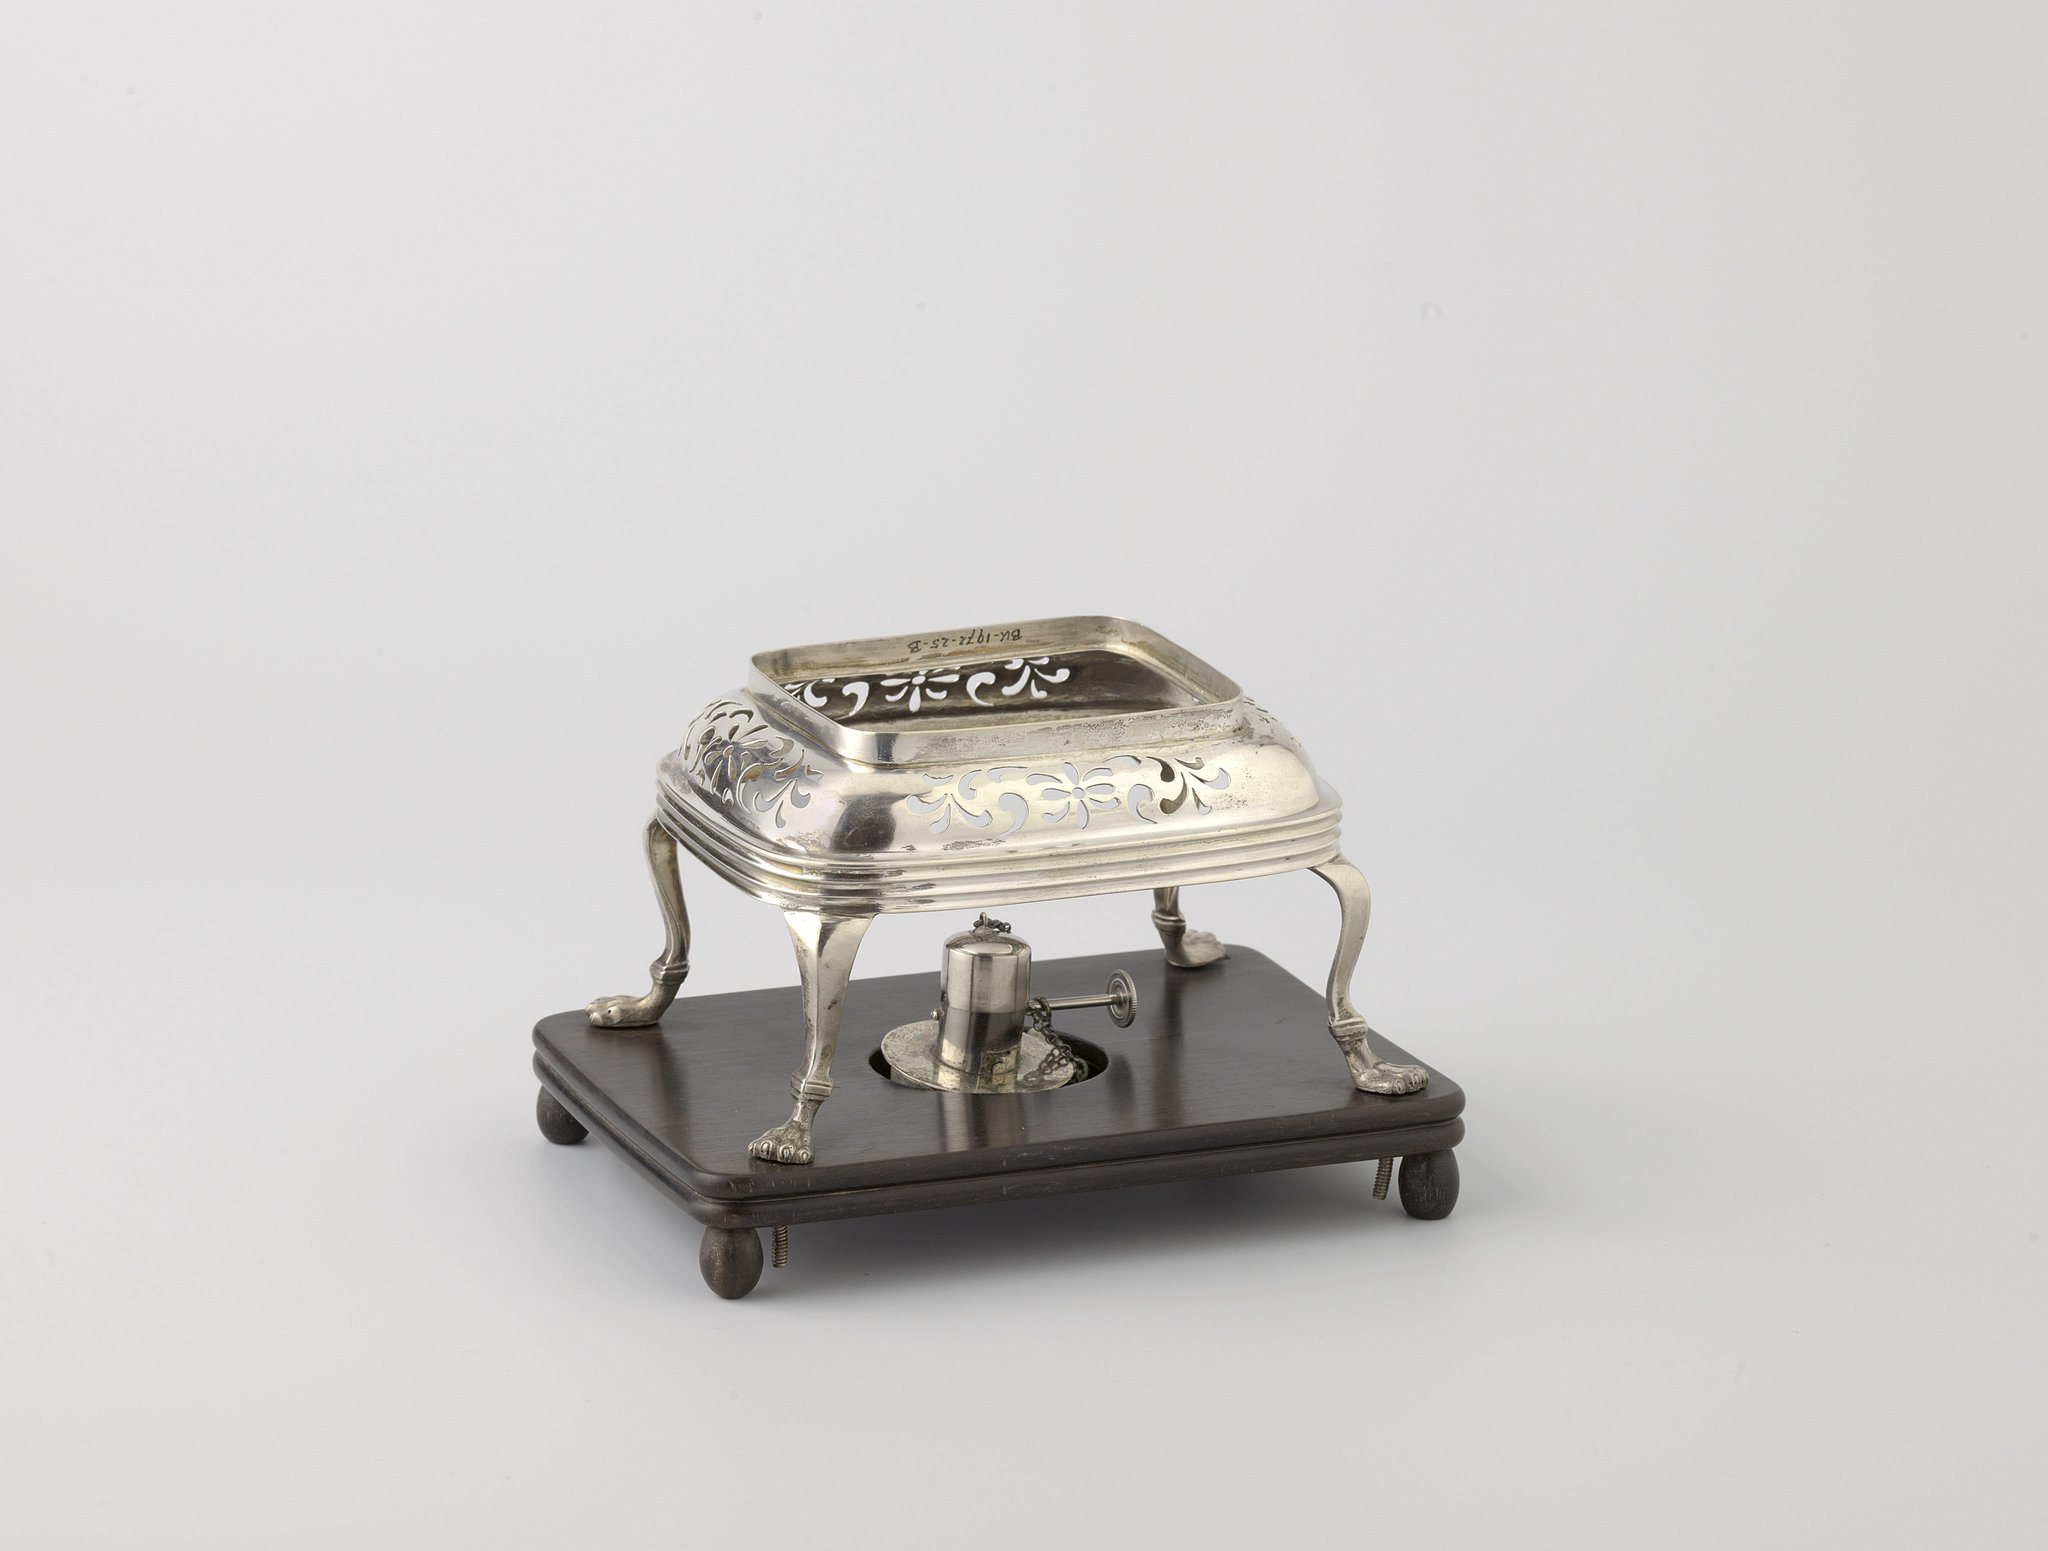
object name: komfoor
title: Komfoor, behorend bij koffiekan, op vier vogelklauwpoten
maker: Anonymous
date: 1839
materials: silver, wood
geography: netherlands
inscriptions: mark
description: Komfoor van zilver. Het rust op vier hoge gebogen poten op vogelklauwen. Het komfoor heeft een met bloem- en bladmotieven opengewerkte wand en een gladde rechte bovenrand waarin de rechtwandige basis van de pot past.